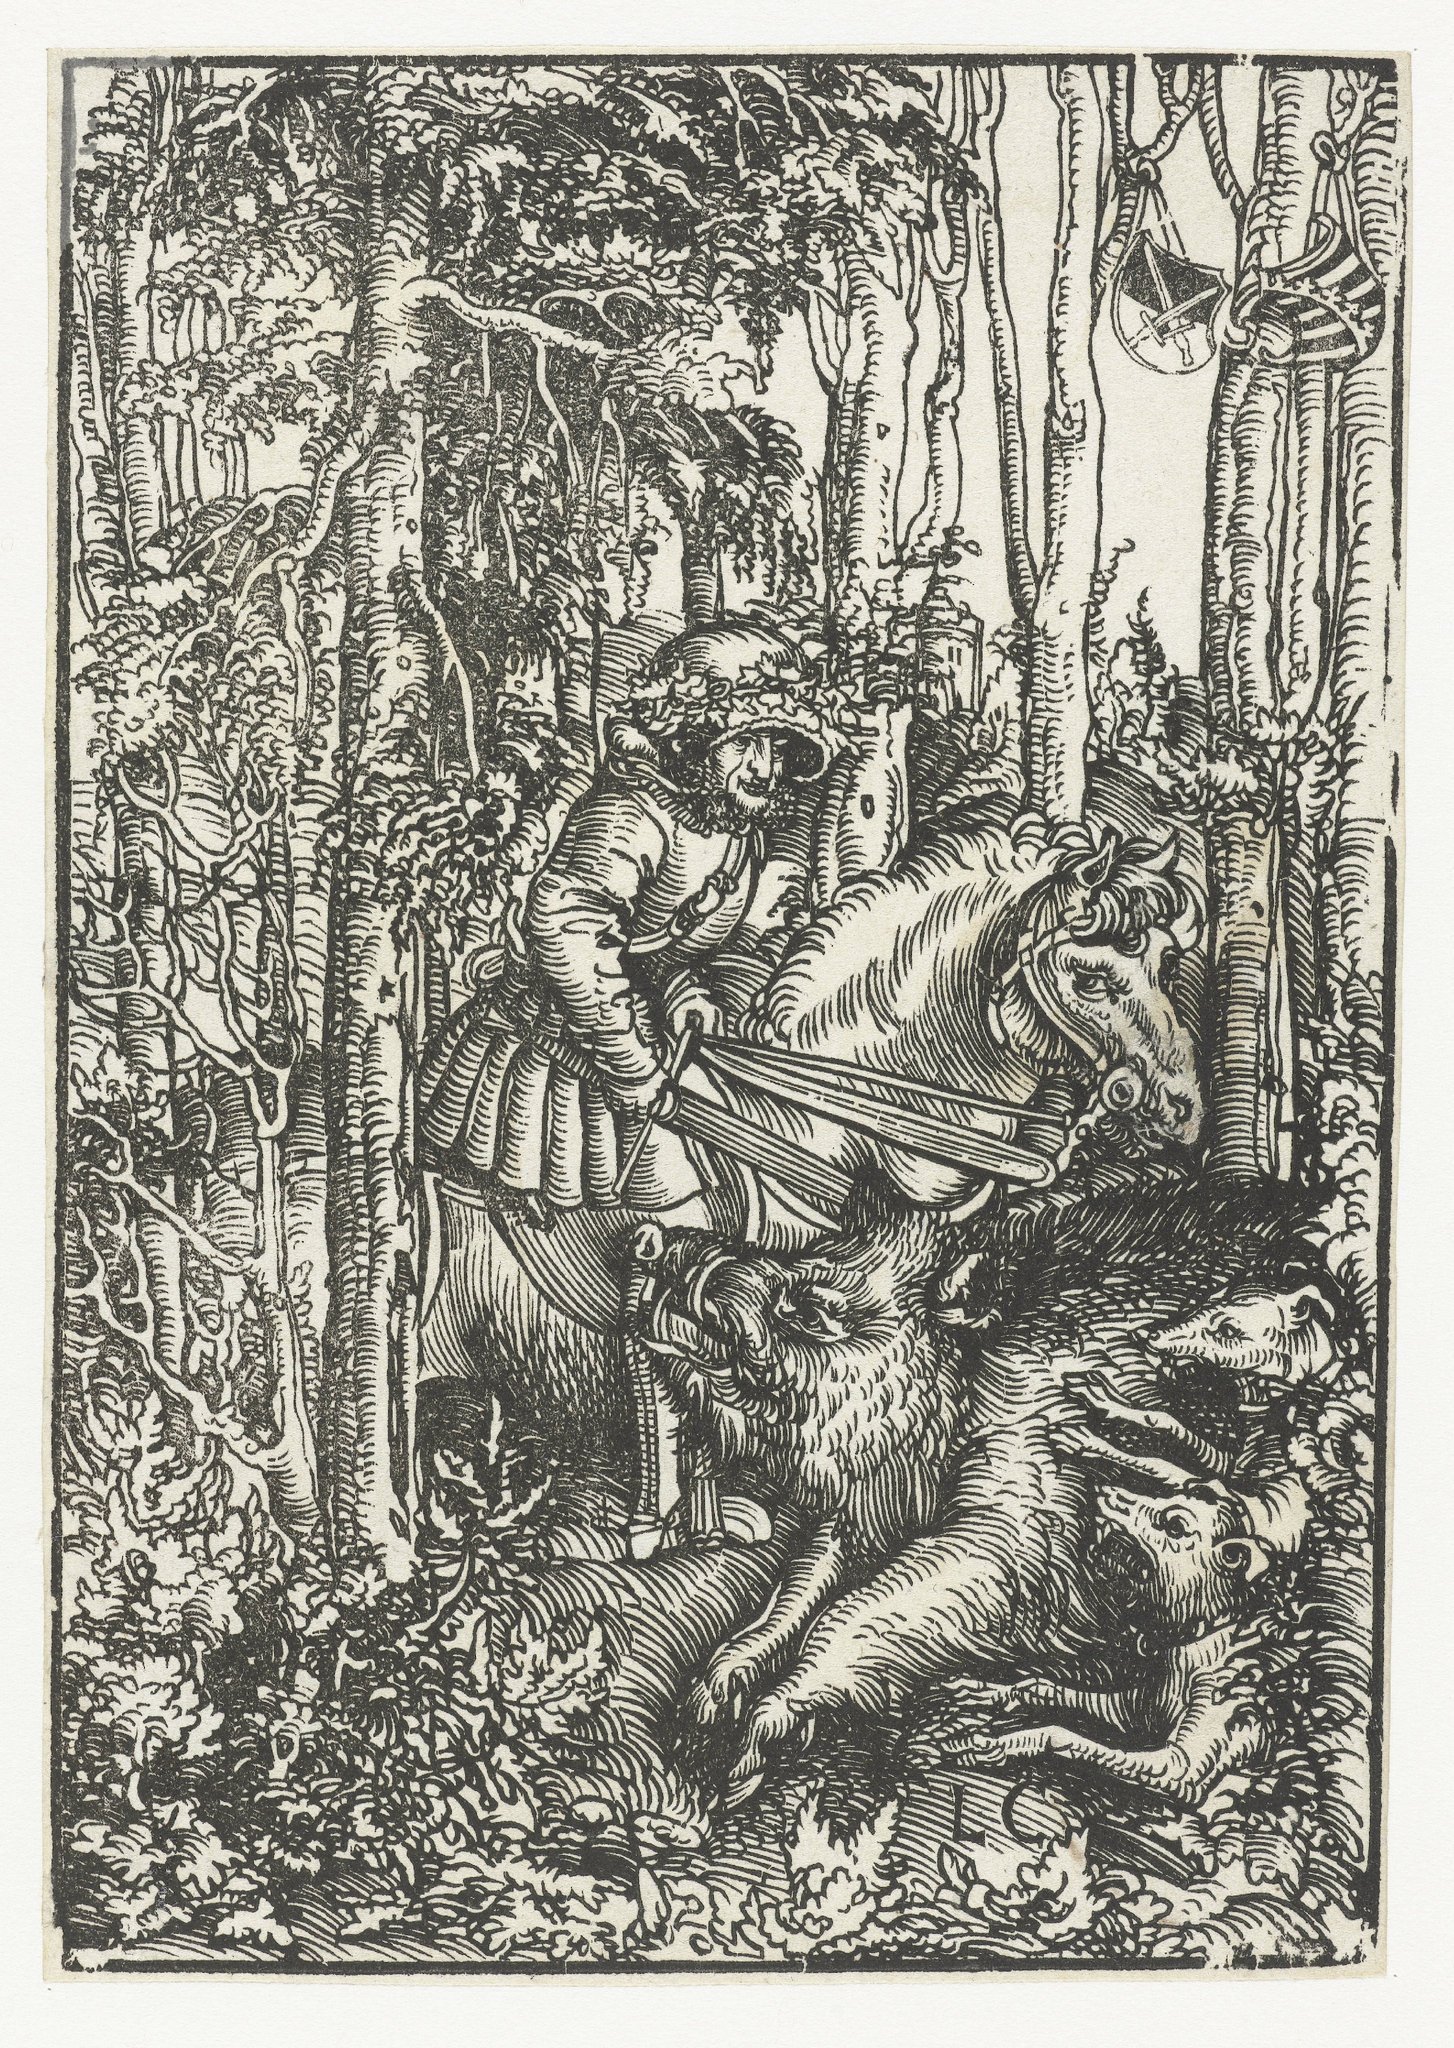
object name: print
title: Man te paard jaagt op wild zwijn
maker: lucas cranach (i)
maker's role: draughtsman, print maker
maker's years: 1472-1553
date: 1505-1553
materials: paper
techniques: woodcut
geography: germany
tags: hunter, hoofed animals: boar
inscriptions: collector's mark: Lugt 240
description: Man te paard jaagt in een bos op een wild zwijn dat opgejaagd en aangevallen wordt door twee honden. De man trekt zijn zwaard om het dier te doden. Rechtsboven hangen in een boom twee schilden met het keurvorstelijk en hertogelijk wapen van Saksen.